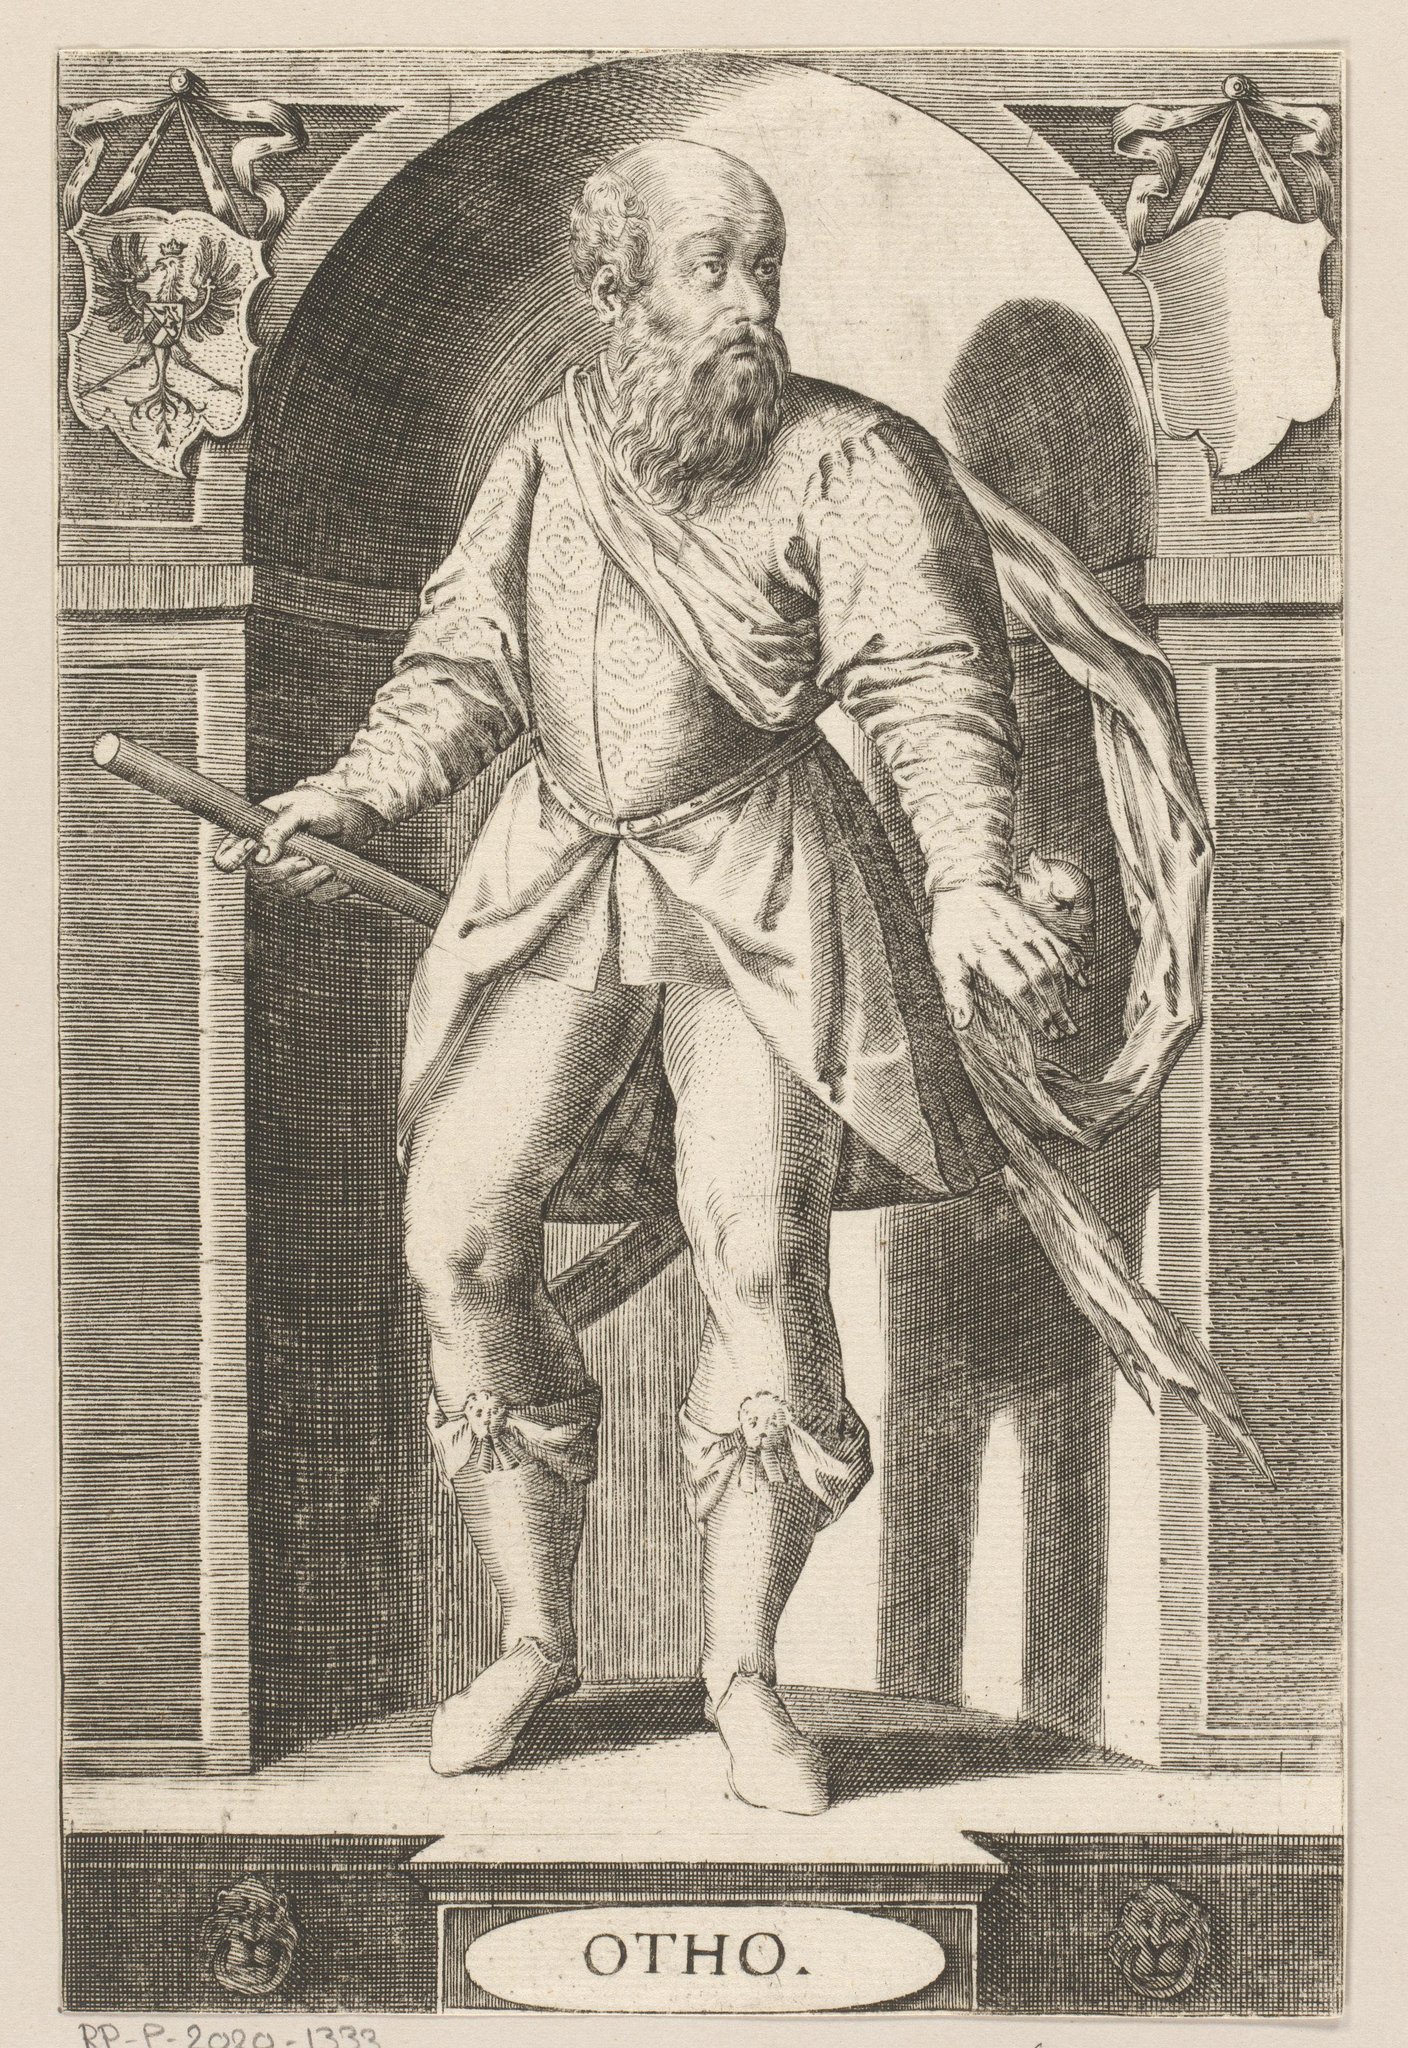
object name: print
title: Otho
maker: dominicus custos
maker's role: print maker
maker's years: 1560-1615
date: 1599-1623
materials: paper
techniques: engraving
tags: earl, historical persons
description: Prent waarschijnlijk voor het eerst verschenen in: Henning, Marcus. Tirolensium Principum Comitum. Augsburg: Johannes Praetorius, 1599. Prent ook gebruikt in latere publicaties, in ieder geval tot in 1623.